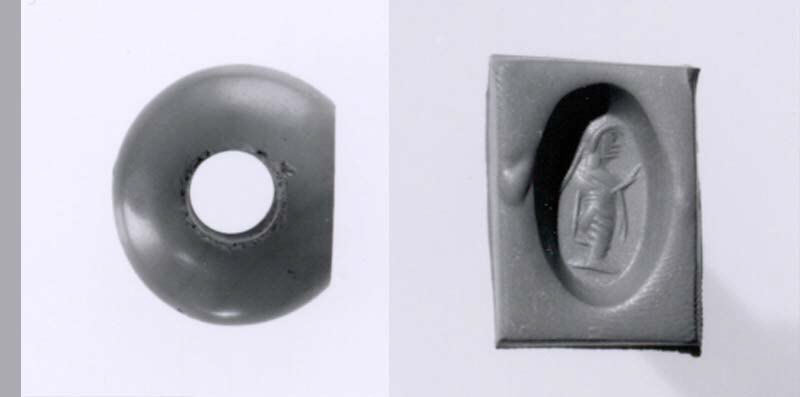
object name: stamp seal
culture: sasanian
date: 201-700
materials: gemstone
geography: iran or mesopotamia